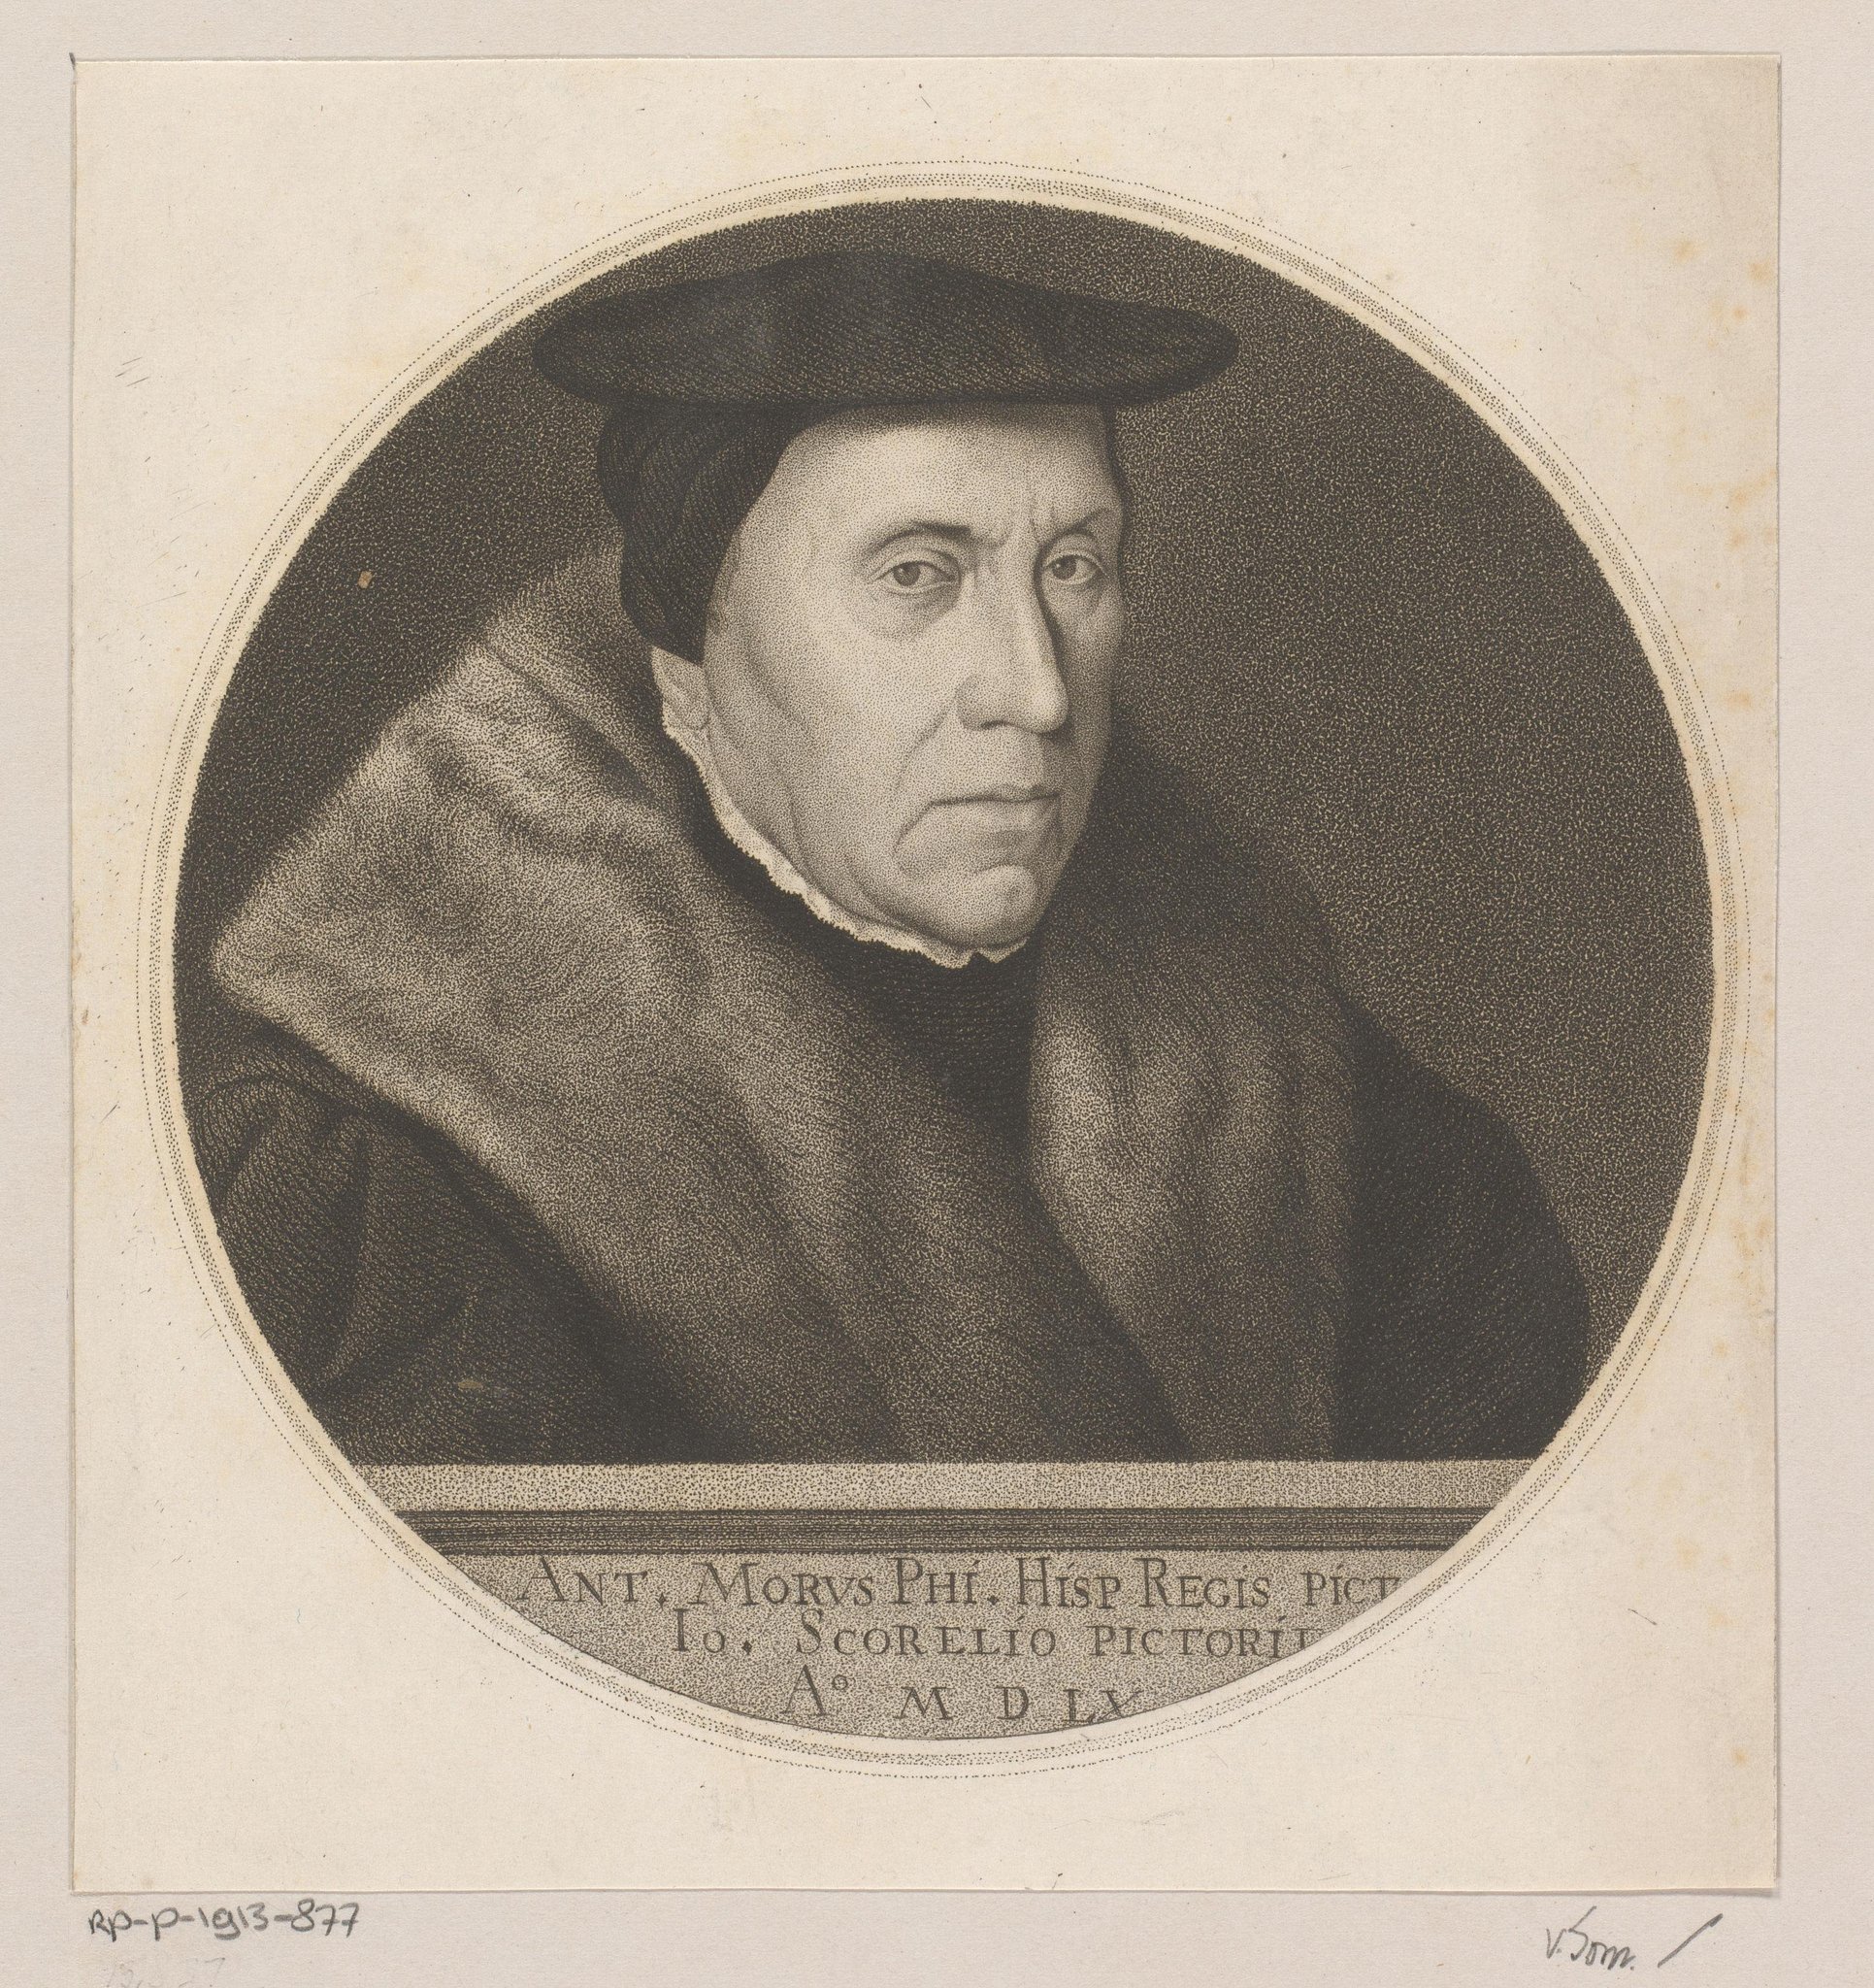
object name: print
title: Portret van Jan van Scorel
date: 1700-1799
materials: paper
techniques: engraving, etching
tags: utrecht, painter, draughtsman, jan van scorel, historical persons, portrait, self-portrait of artist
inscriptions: collector's mark: Lugt 2228